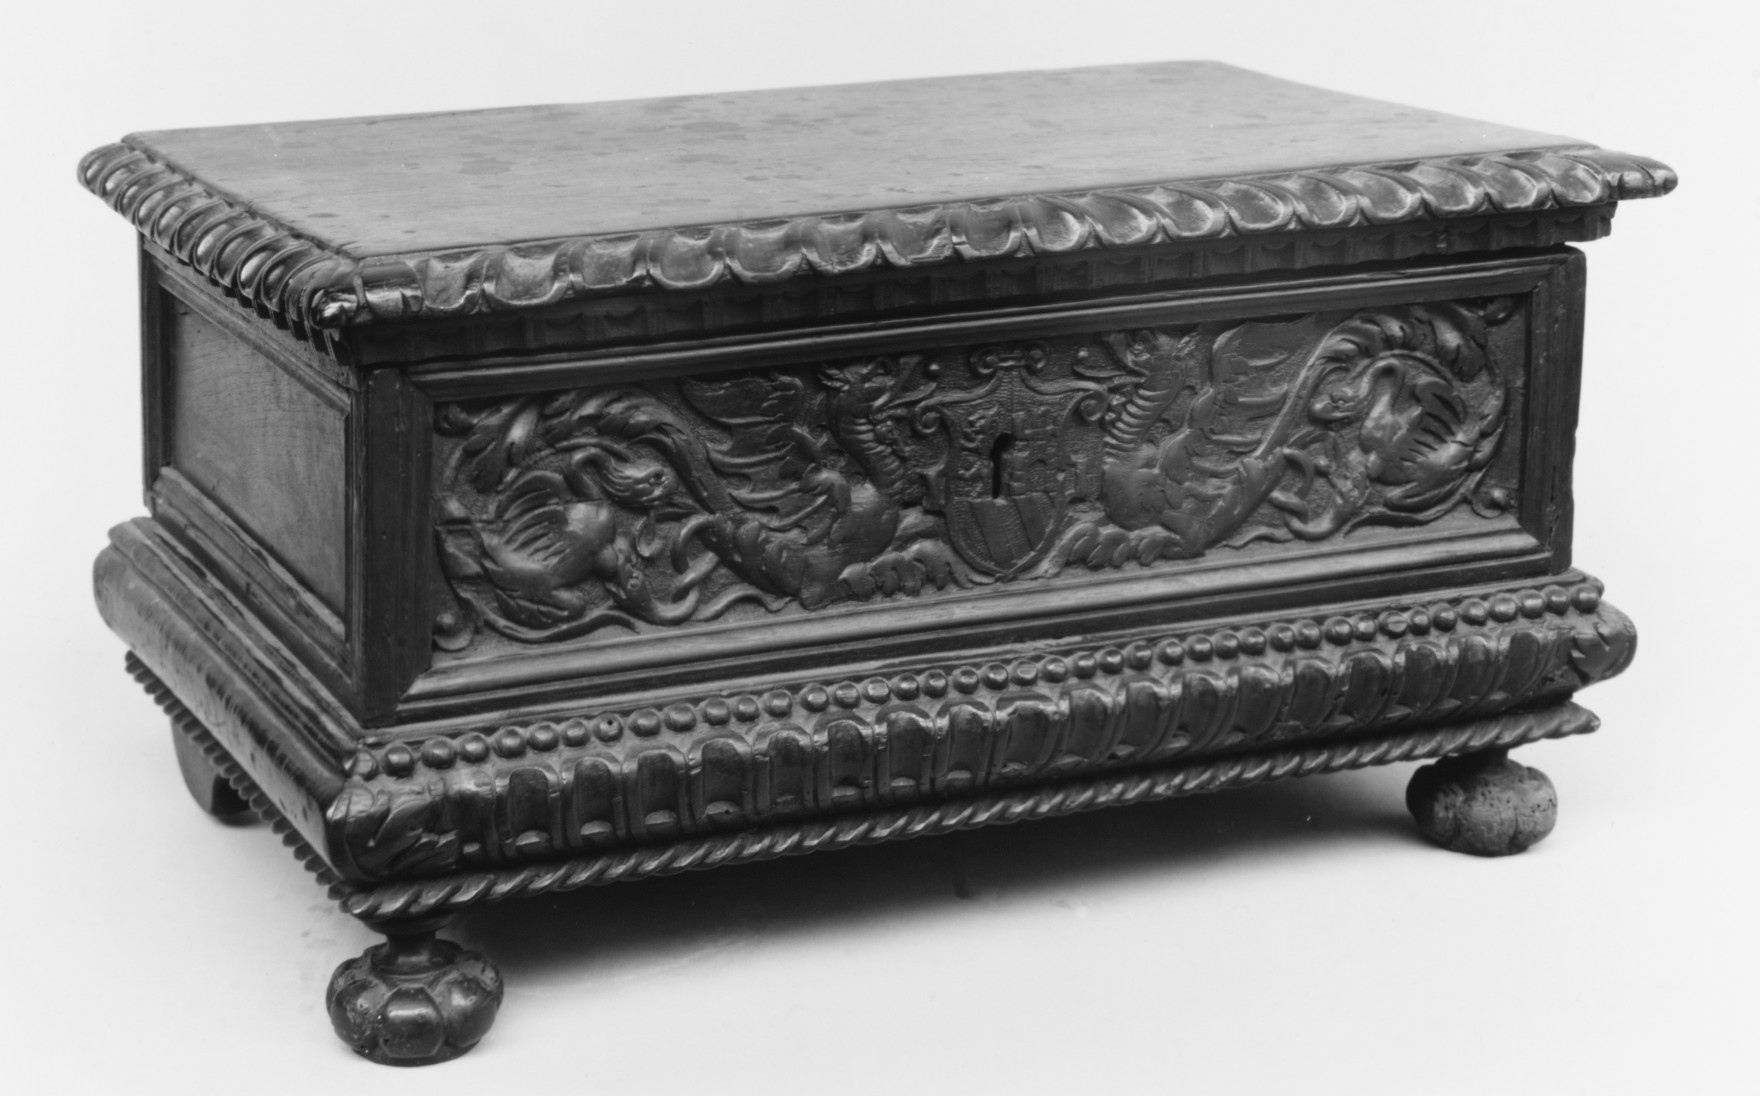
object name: casket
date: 1501-1550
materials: wood